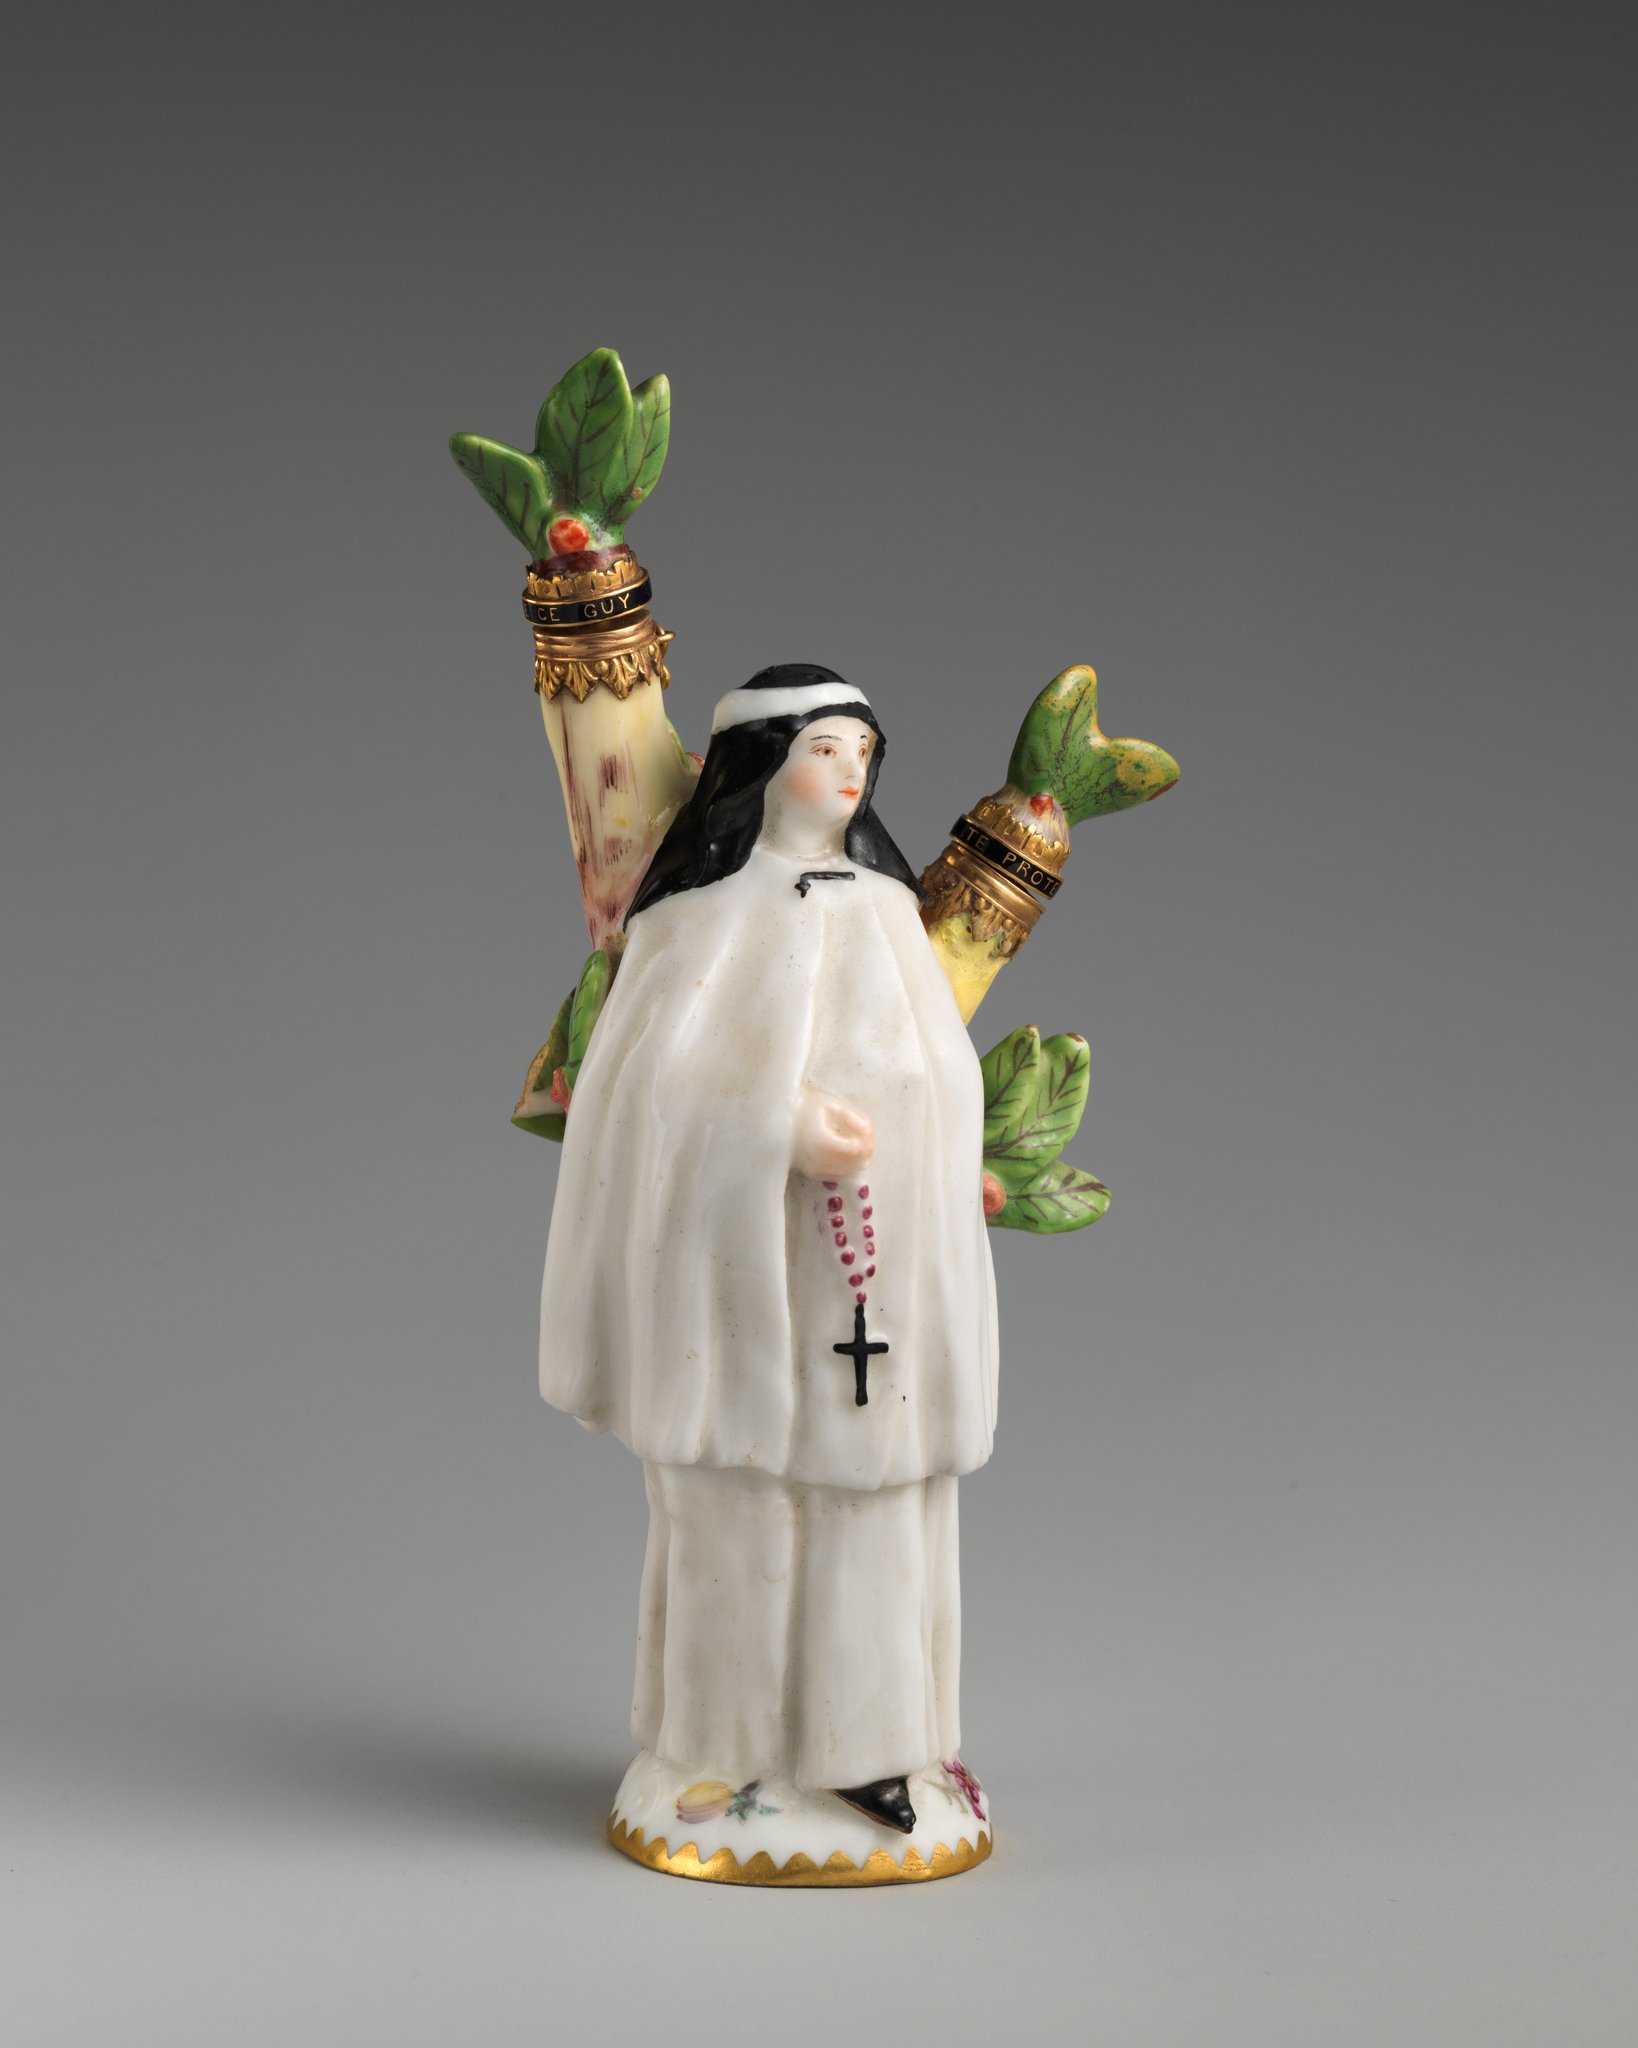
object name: scent bottle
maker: chelsea porcelain manufactory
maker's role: factory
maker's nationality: british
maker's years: 1744-1784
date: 1756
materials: soft paste porcelain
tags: women,rosaries